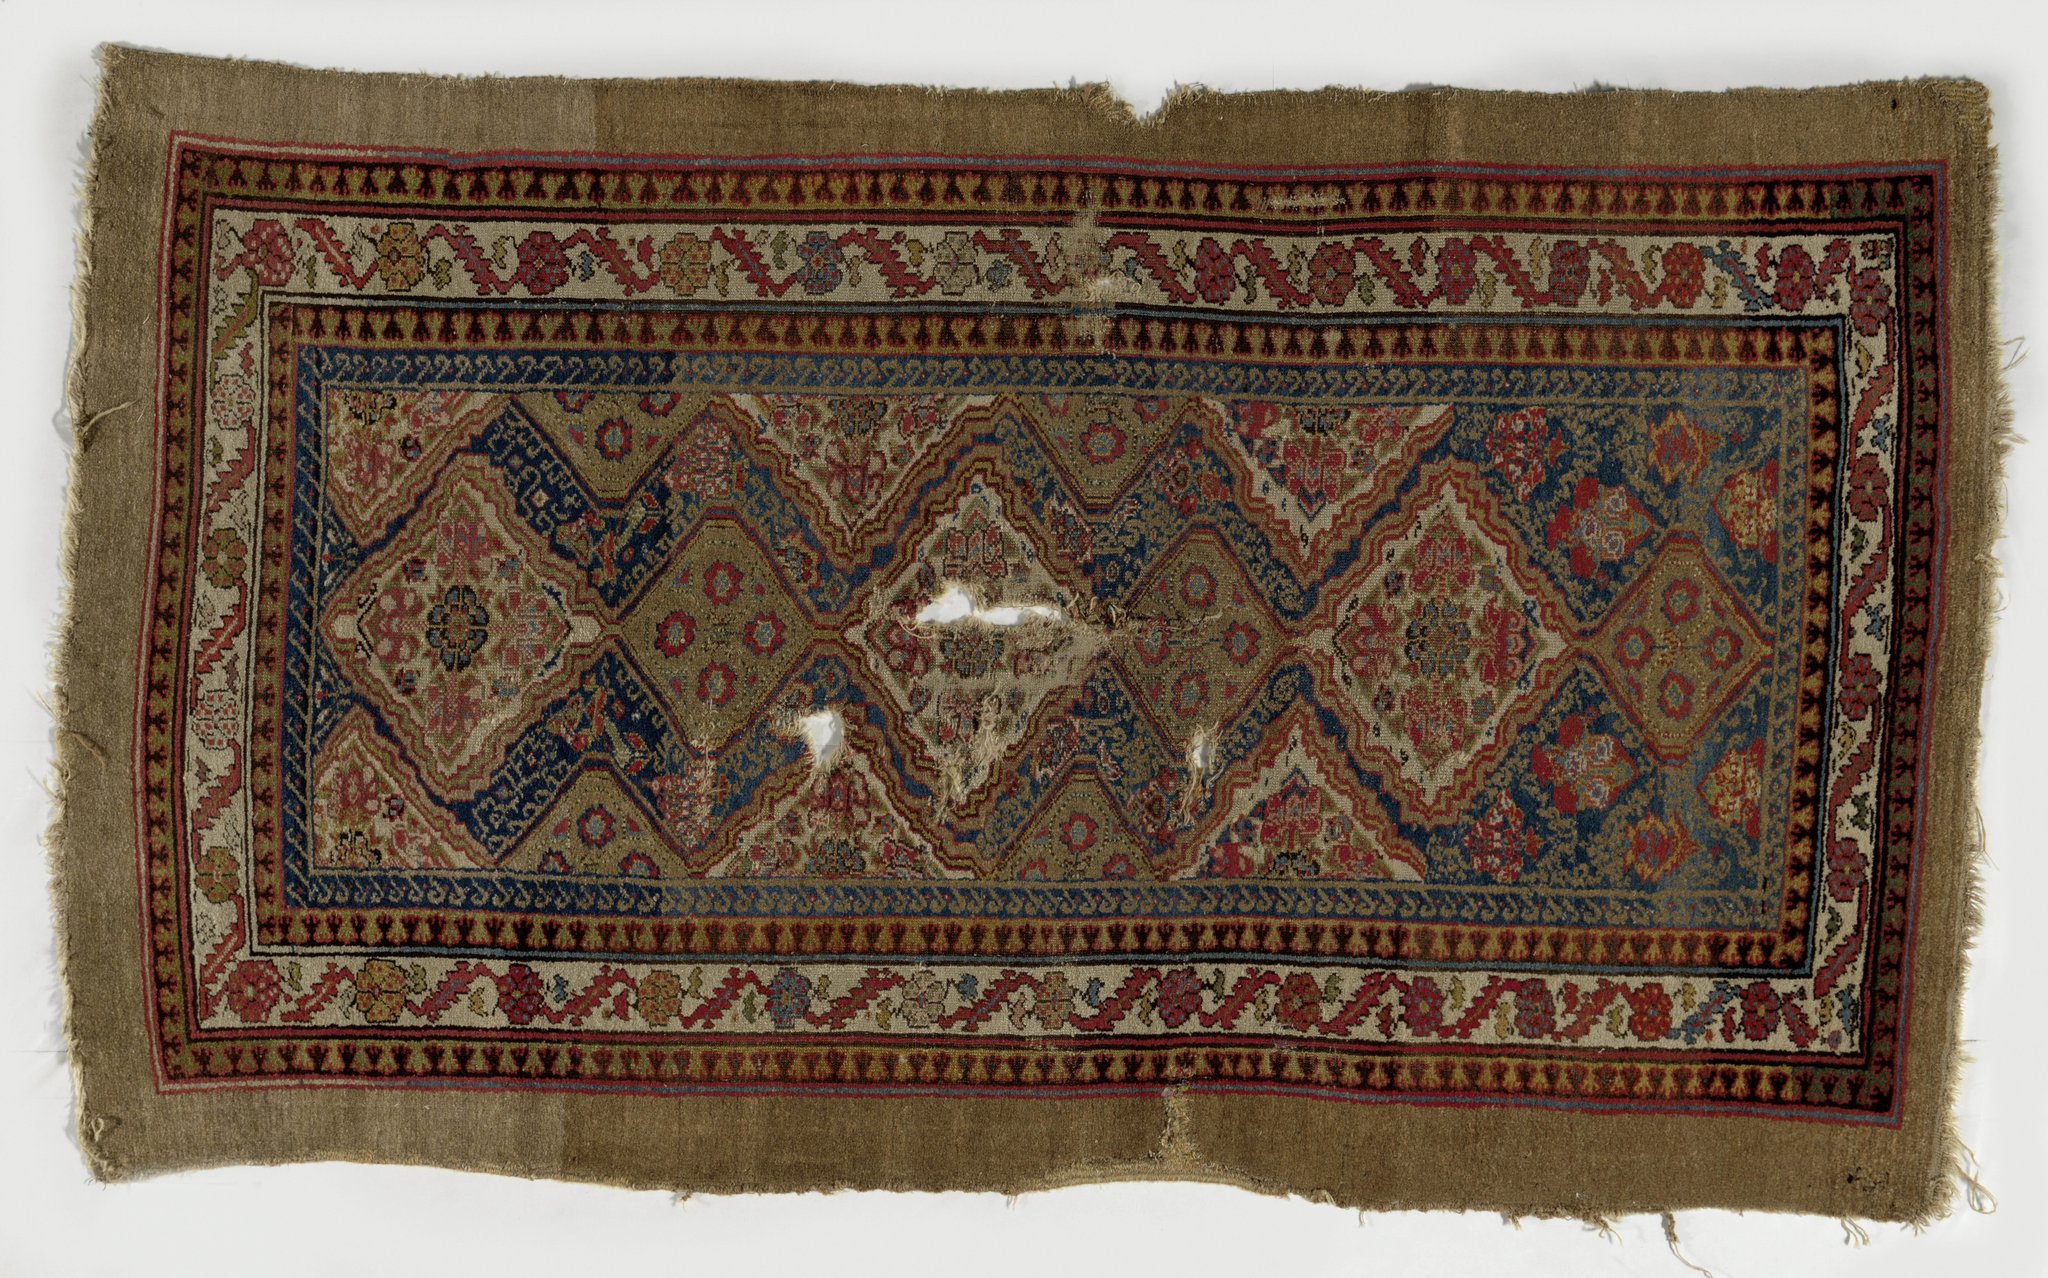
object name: oriental rug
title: Oosters tapijt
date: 1850-1900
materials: wool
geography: hamadan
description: Oosters tapijt, medaillonkleed, van geknoopte wol. Op het middenveld staan zes ruitvormige medaillons, palmetten en rozetten. Langs de randen gehalveerde medaillons. Rondom vijf randen, waarvan de breedste versierd is met een spiraalband en rozetten.